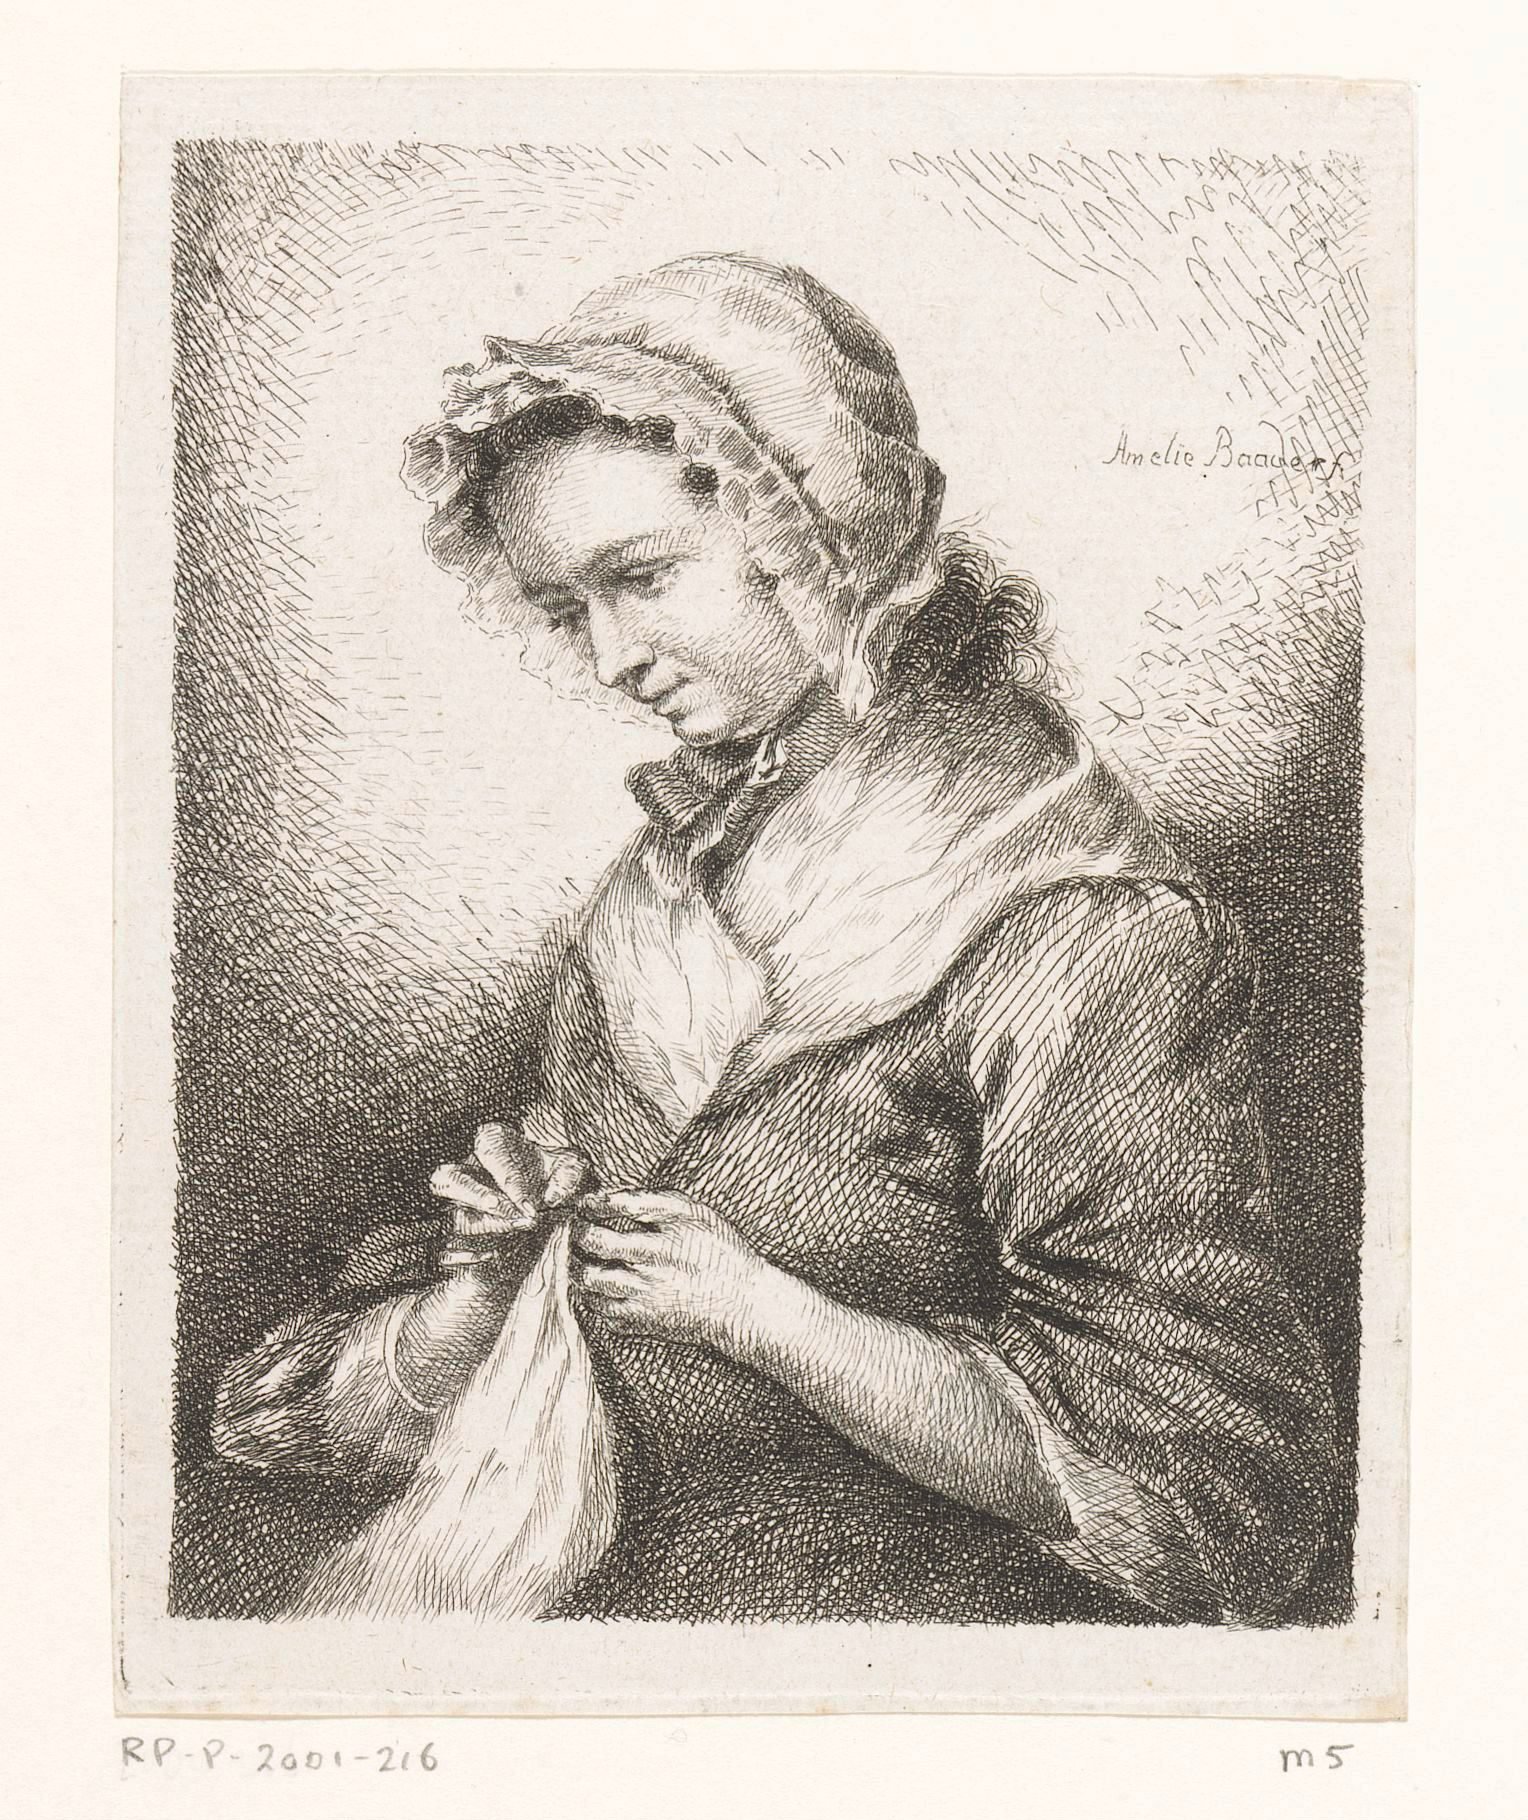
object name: print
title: Portret van de vrouw van de kunstenaar Georg Friedrich Schmidt, naaiend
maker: amalie baader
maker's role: print maker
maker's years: 1763-1840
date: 1773-1840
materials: paper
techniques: etching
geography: germany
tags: historical persons - bb - woman, sewing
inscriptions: collector's mark: Lugt 2228, collector's mark: Lugt 2760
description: Portret van Dorothea Louise Schmidt, geboren Viedebandt, de vrouw van de kunstenaar Georg Friedrich Schmidt. Ze draagt een kanten muts en is naar links gekeerd.